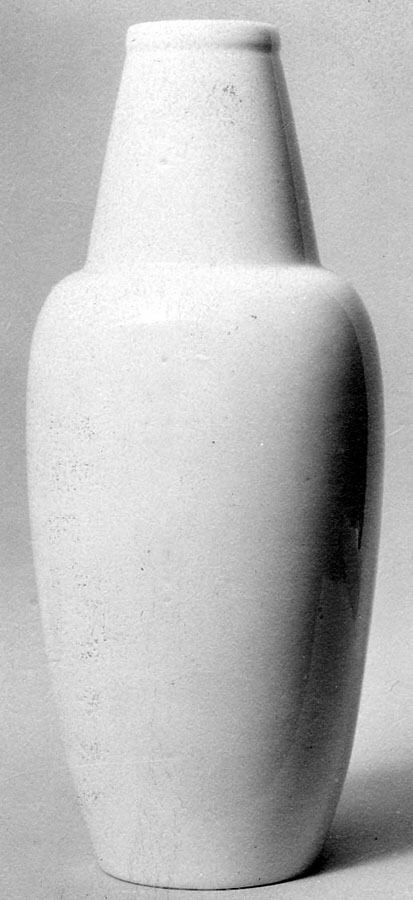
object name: vase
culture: chinese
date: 1736-1795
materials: glass